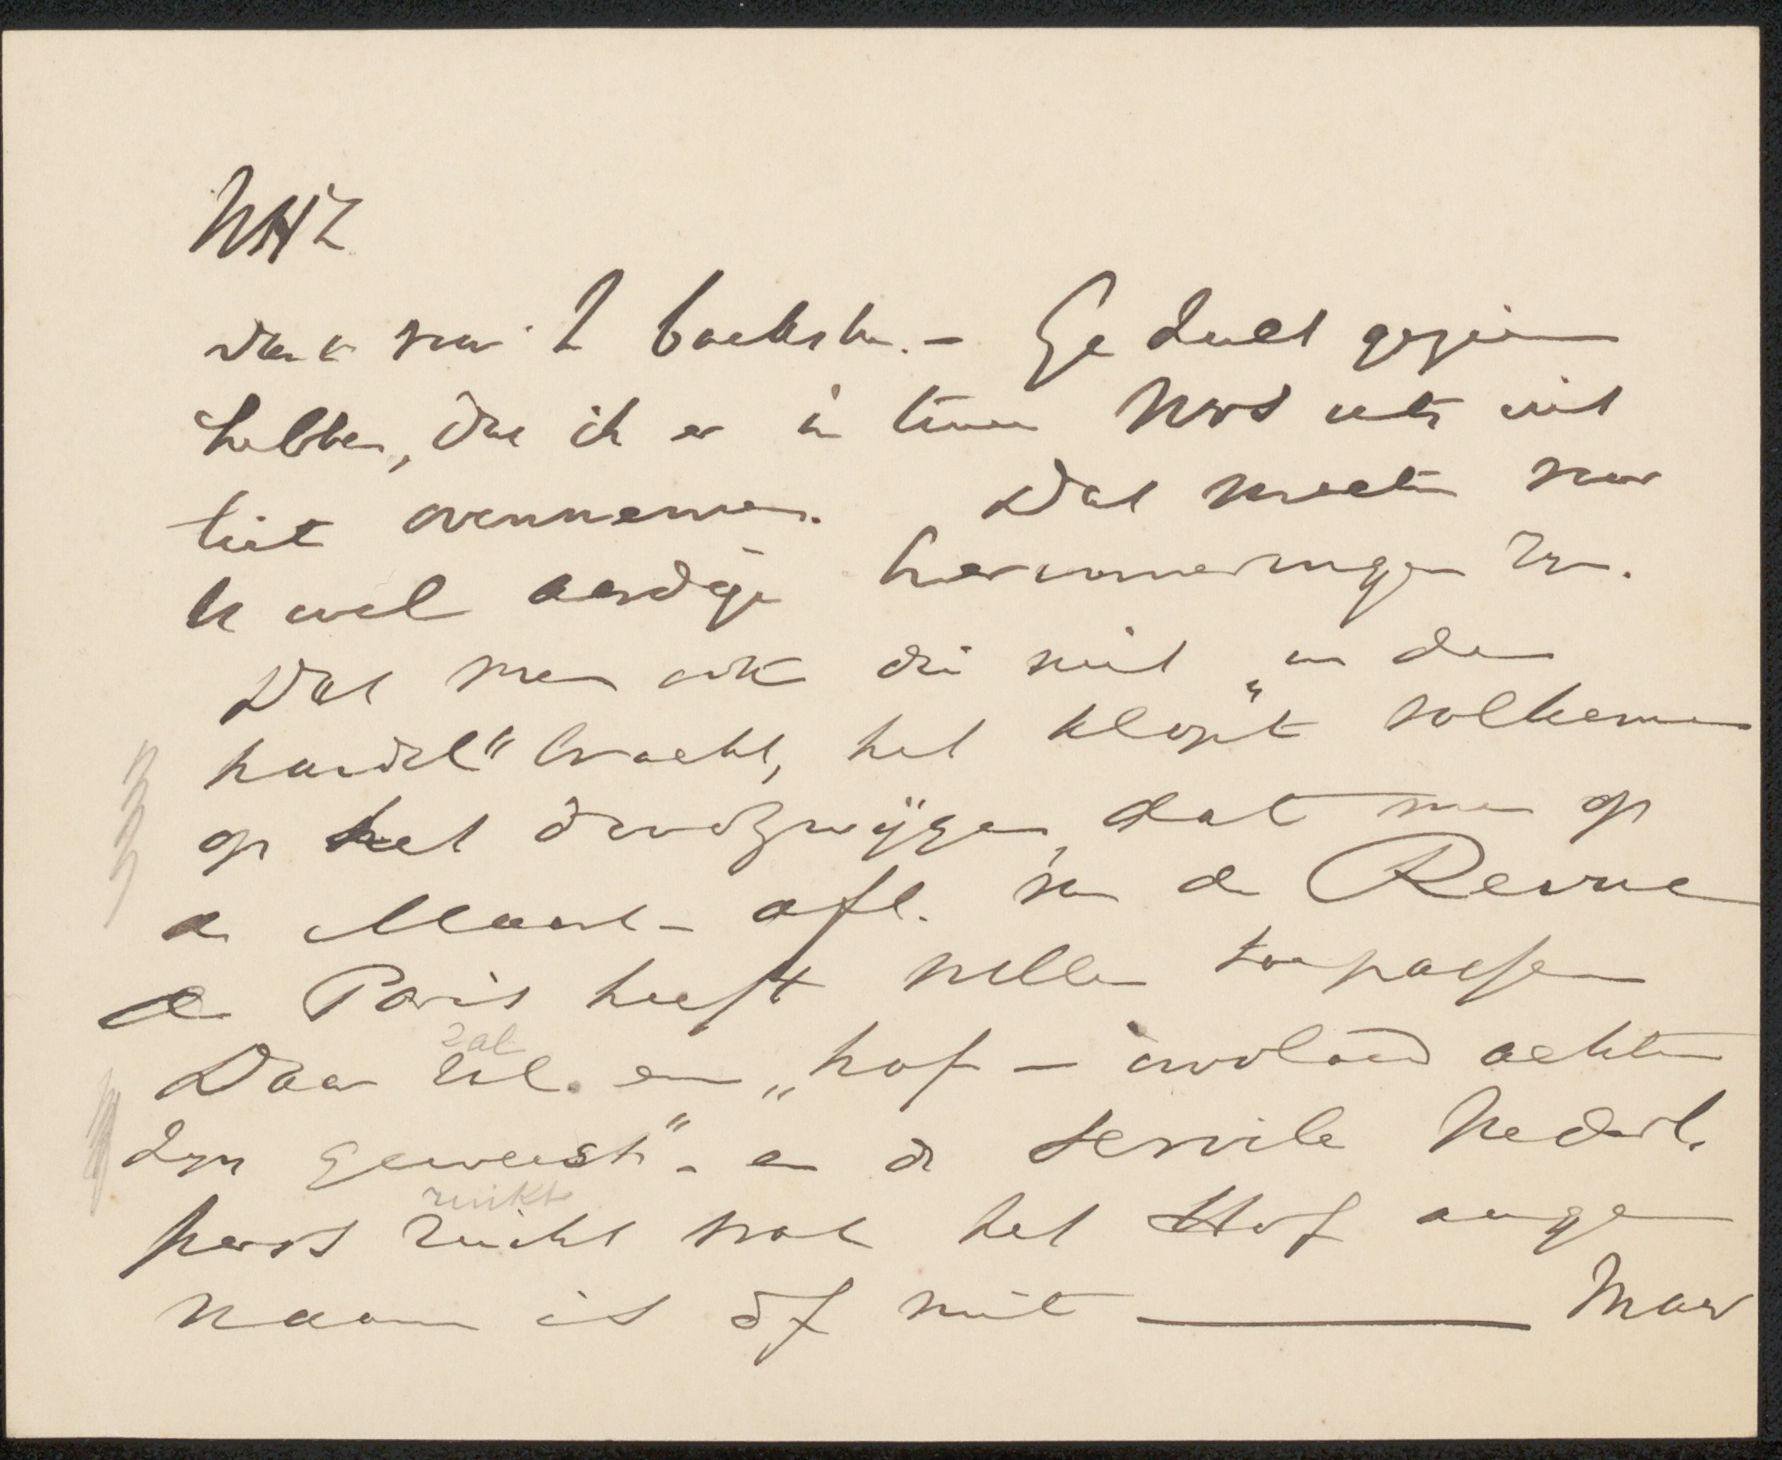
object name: letter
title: Brief aan Philip Zilcken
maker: johannes de koo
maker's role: auteur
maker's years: 1841-1909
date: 1903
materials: cardboard, ink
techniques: pen, writing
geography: hilversum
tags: leiden, print maker, rembrandt van rijn, the hague, draughtsman, philip zilcken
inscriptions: collector's mark: ‘RPK’